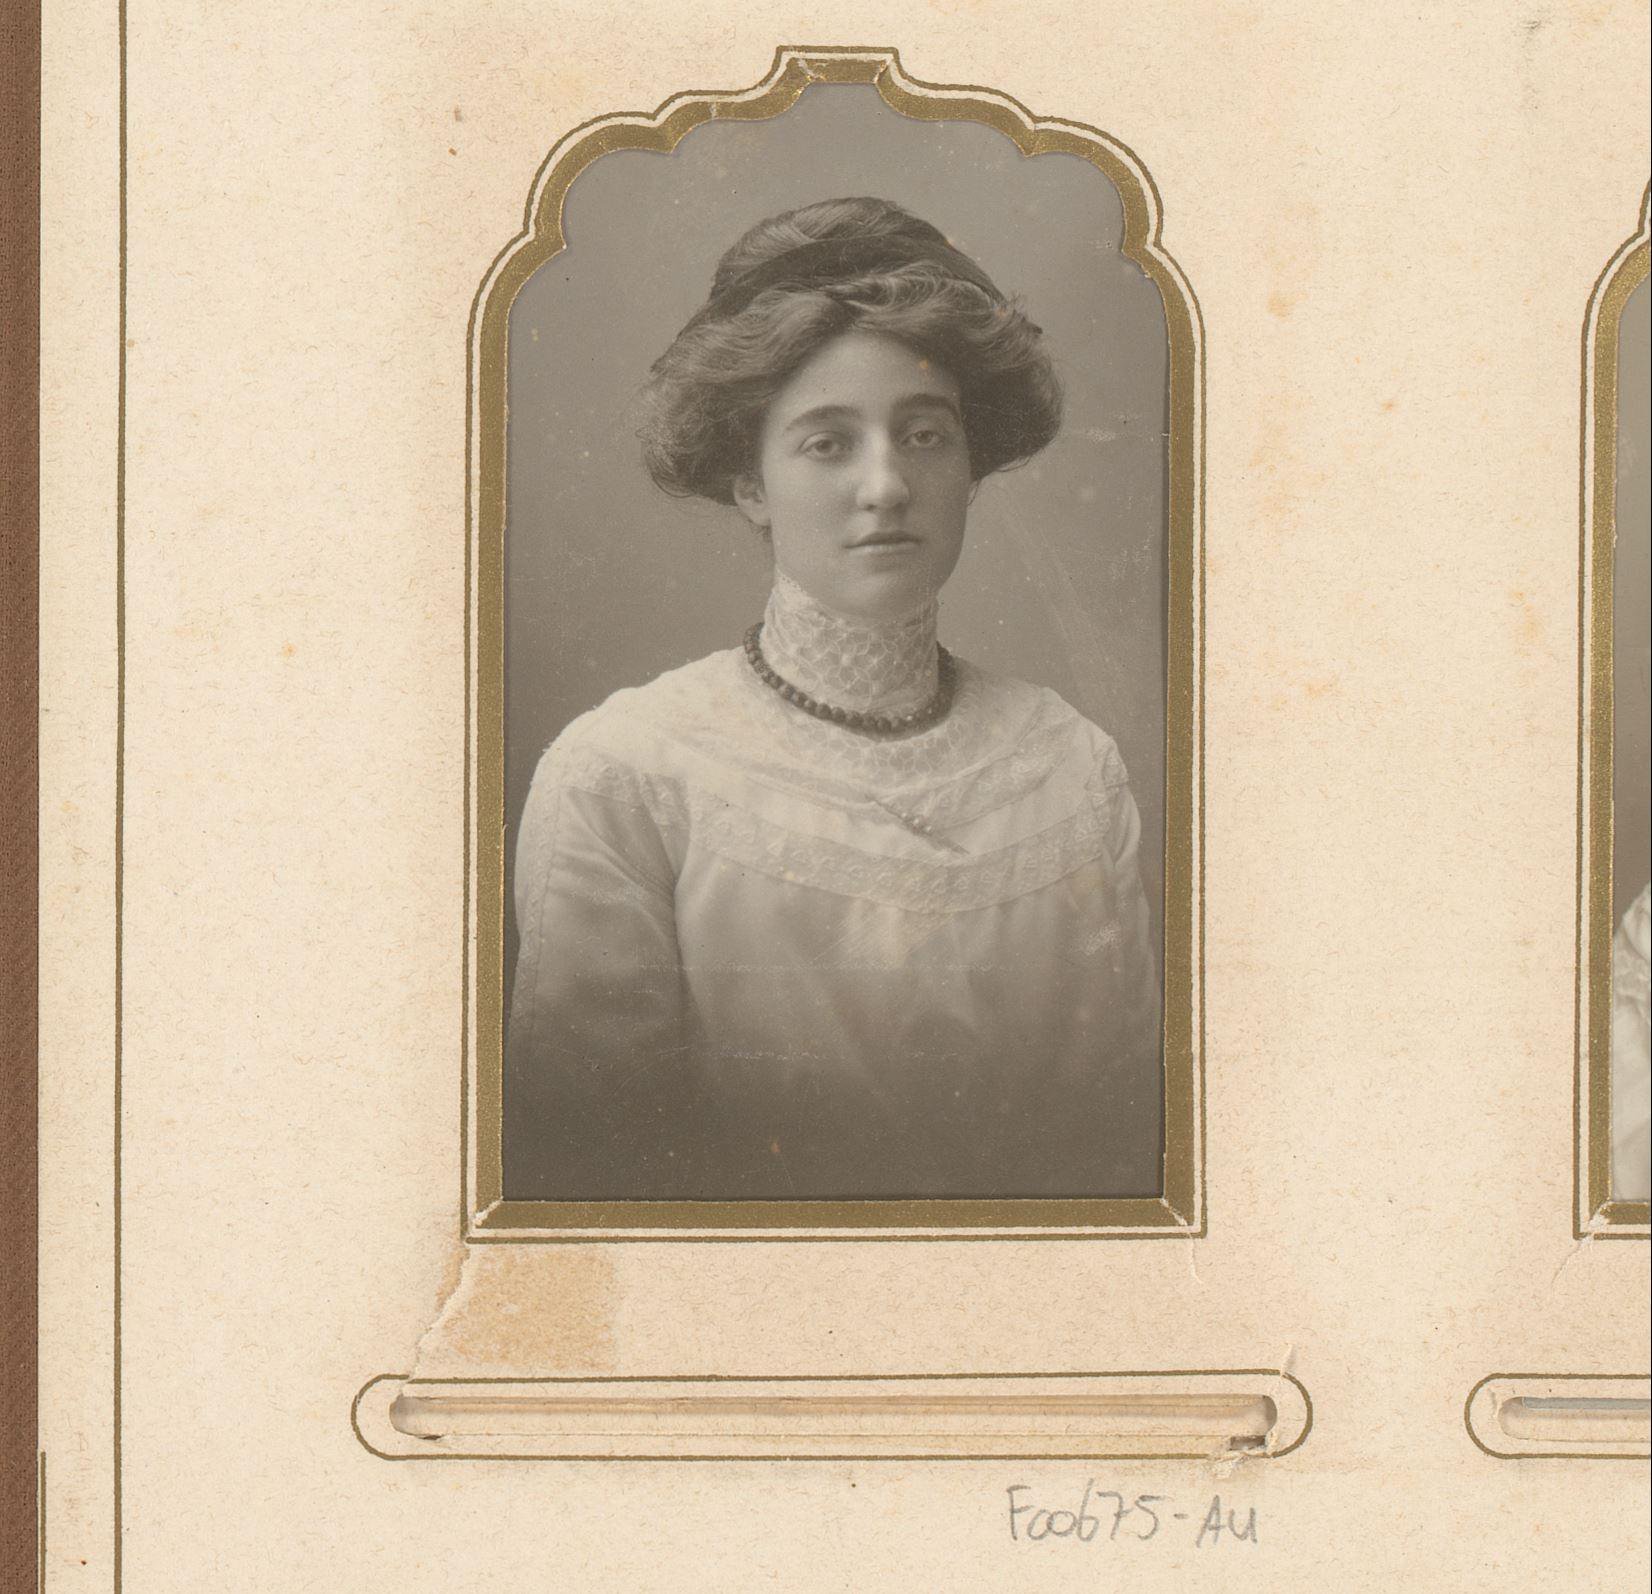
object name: album leaf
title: Portret van een jonge vrouw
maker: pieter saaf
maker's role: fotograaf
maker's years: 1874-1931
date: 1909-1931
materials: cardboard, photographic support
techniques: collodion silver print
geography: zaandam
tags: adolescent, young woman, maiden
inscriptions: inscription: ‘Fotografie artistieck/ P. Saaf/ Ged. Gract nr. 8/ TElefoon 65/ Zaandam (...)’